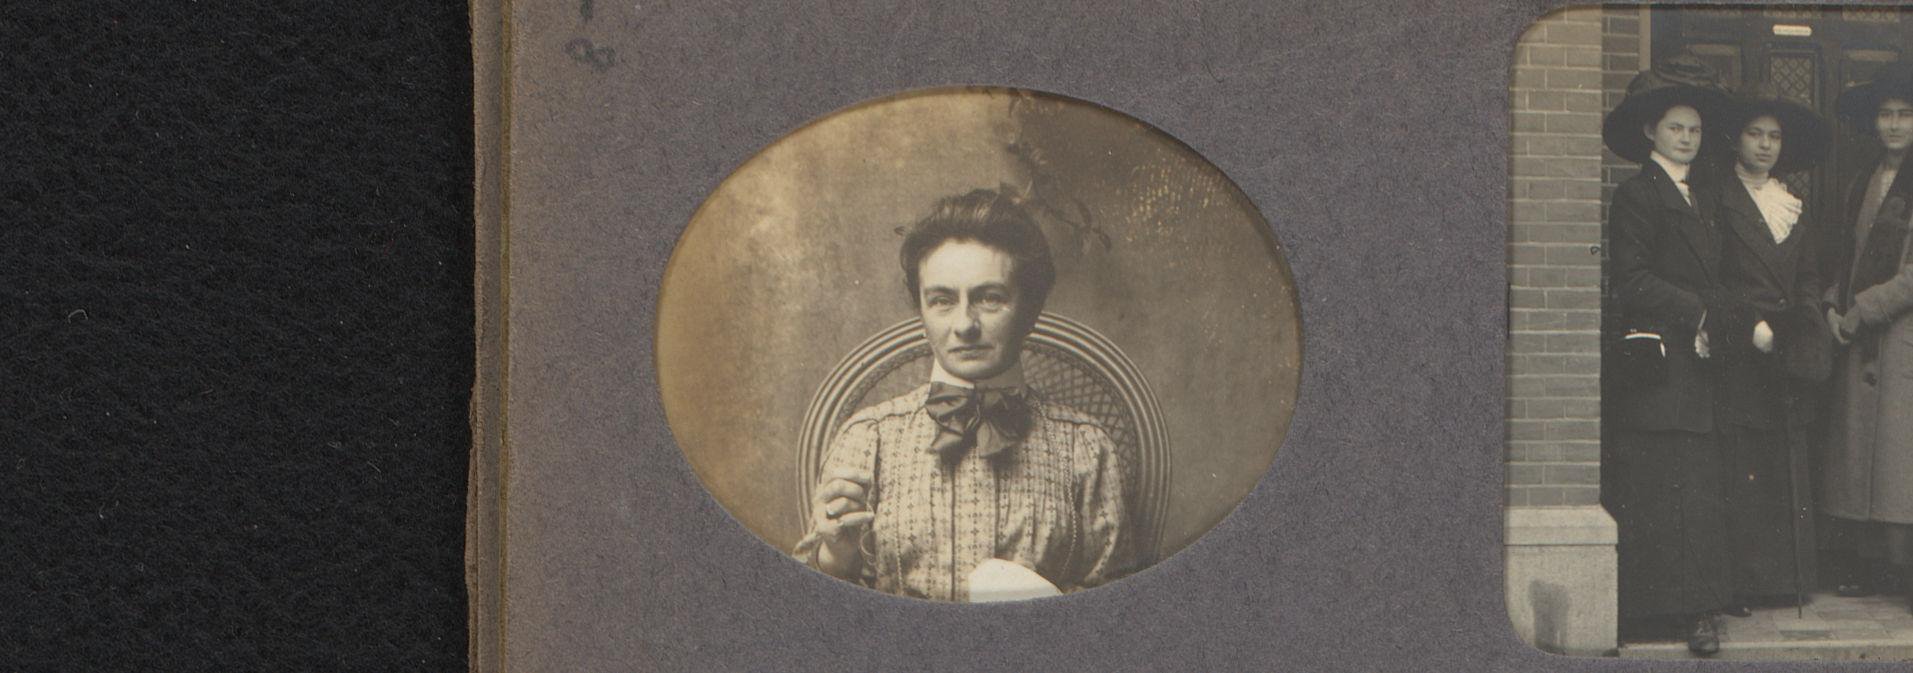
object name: photograph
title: Portret van een vrouw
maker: Anonymous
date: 1905-1912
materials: paper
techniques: gelatin silver print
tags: adult woman, anonymous historical person portrayed